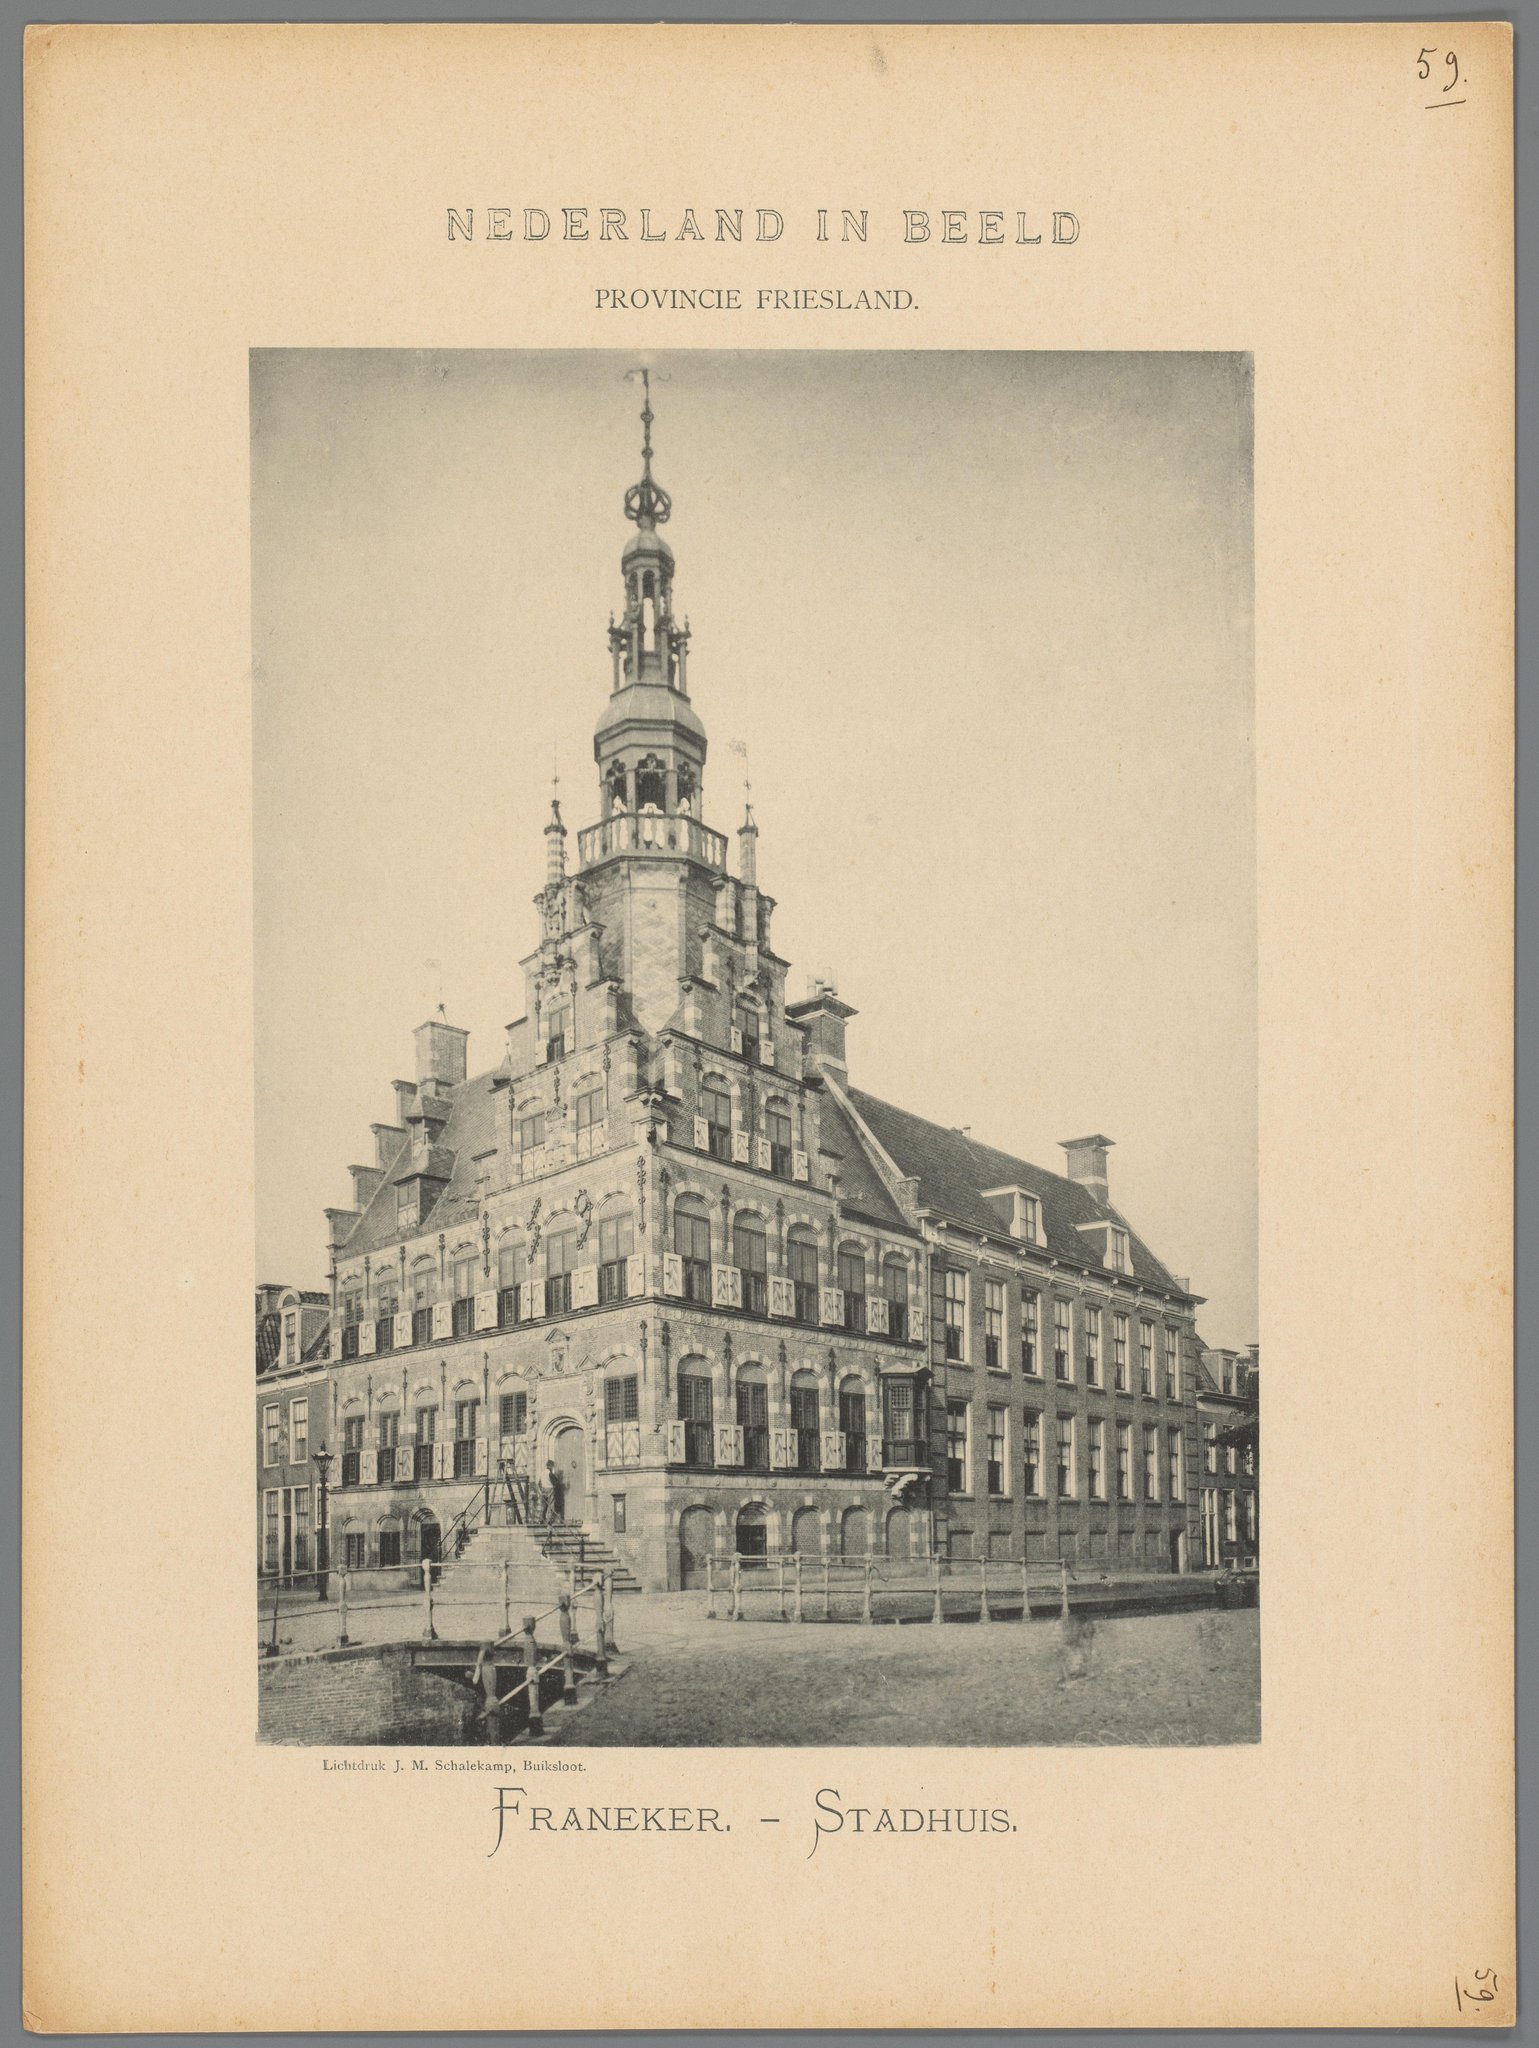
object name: photomechanical print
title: Gezicht op het stadhuis van Franeker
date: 1893-1896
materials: paper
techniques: photograph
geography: groningen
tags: townhall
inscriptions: number: ‘59.’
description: Deze prent maakt deel uit van een omslag met 43 lichtdrukken op 43 bladen.